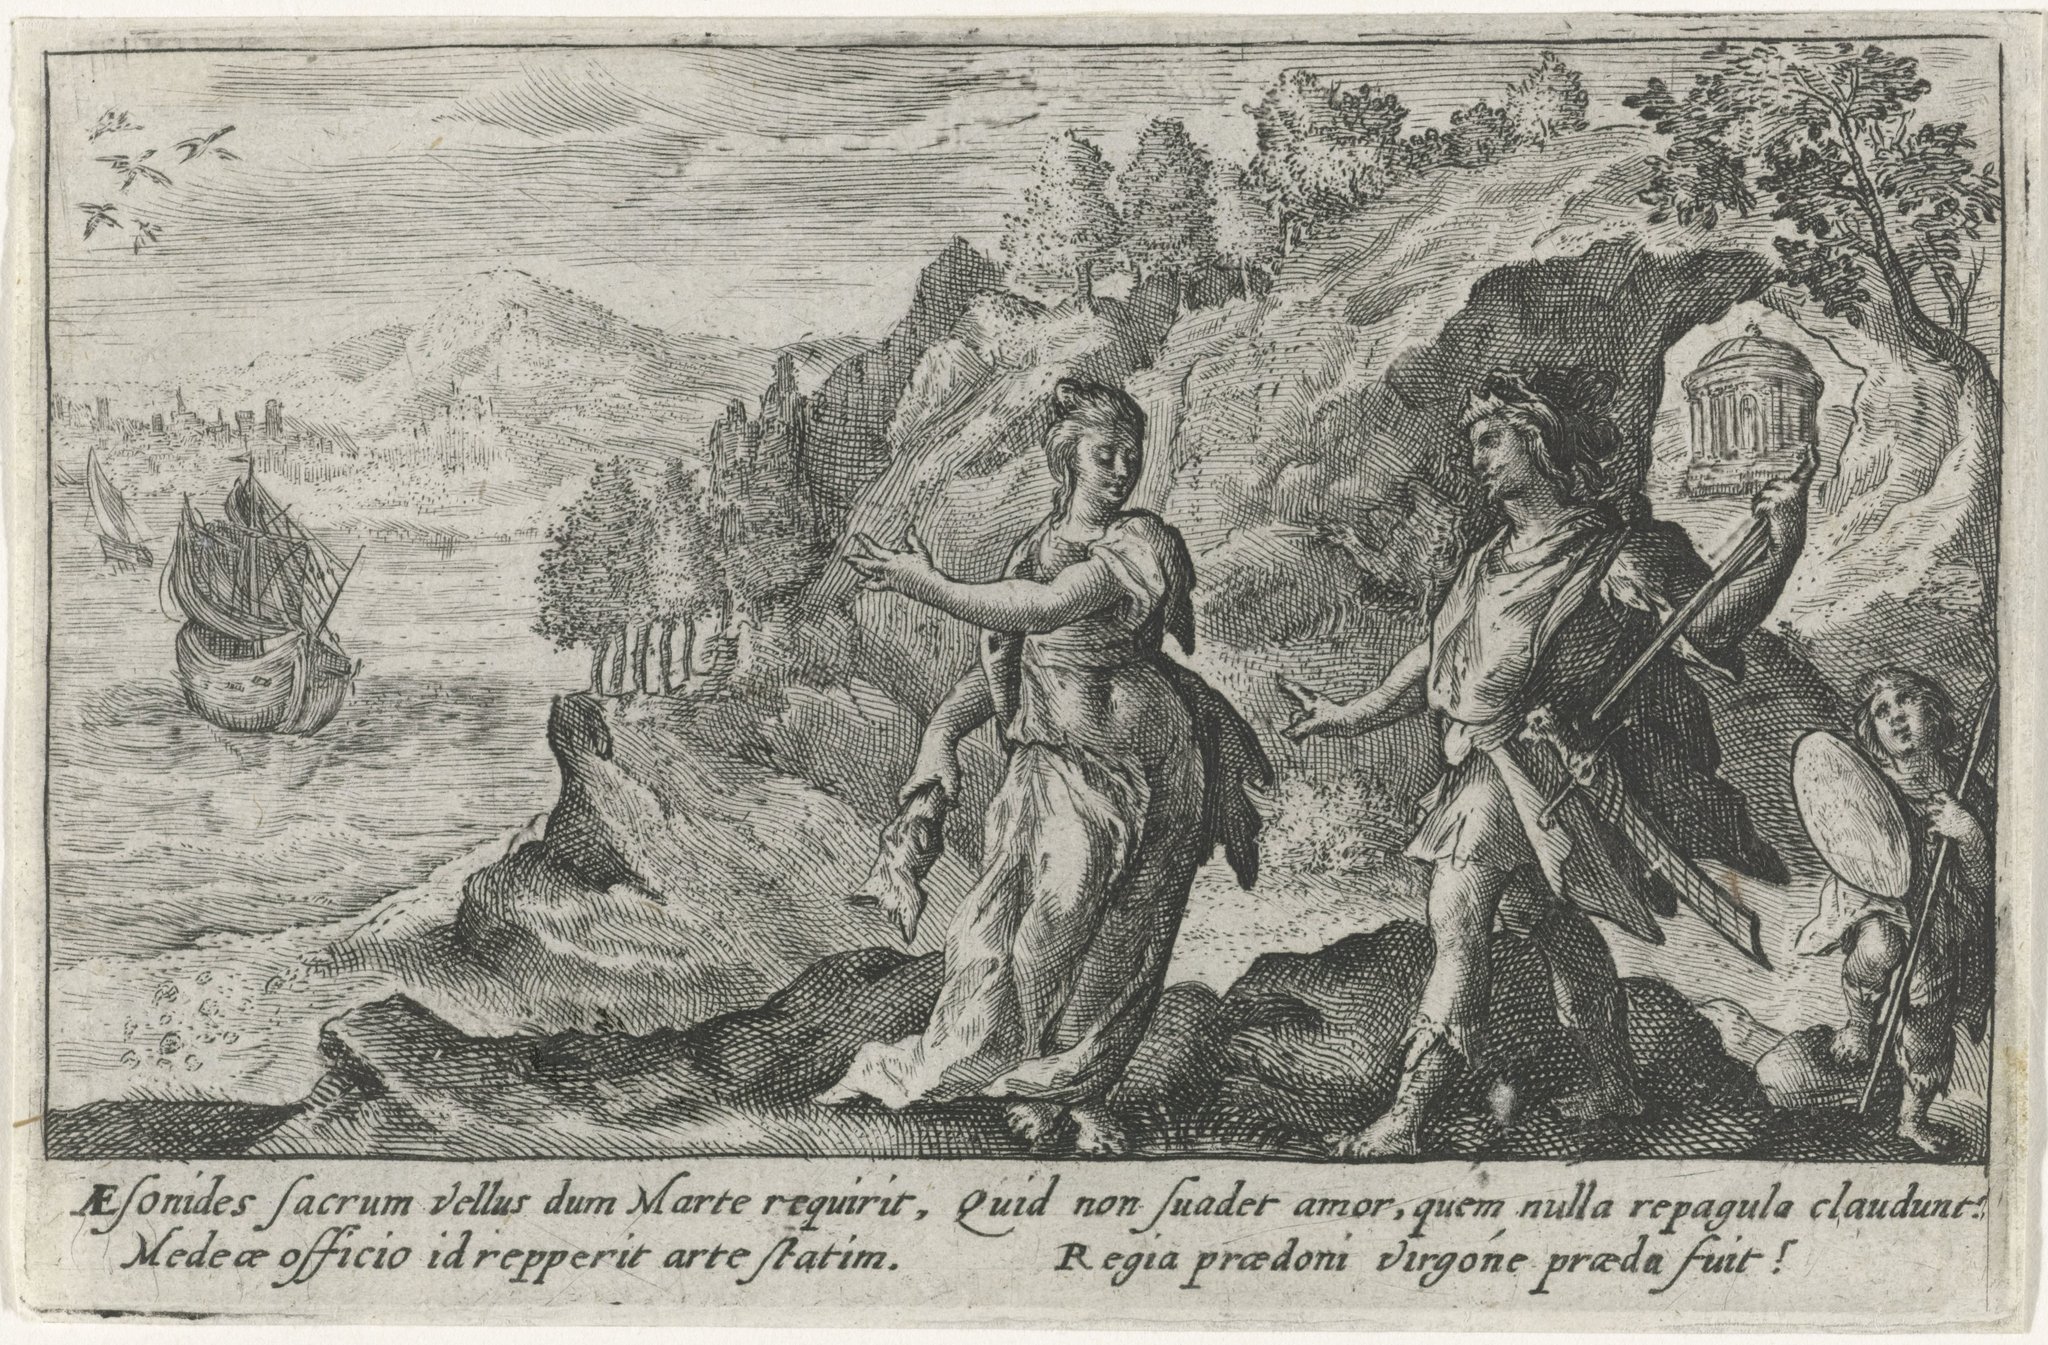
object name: print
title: Metamorfosen van Ovidius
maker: crispijn van de passe (i)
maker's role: draughtsman, print maker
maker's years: 1564-1637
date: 1602-1607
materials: paper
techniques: engraving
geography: cologne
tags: jason and medea at the altar of hecate (or diana): medea gives him a magic herb or ointment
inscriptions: collector's mark: Lugt 2228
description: Medea ontmoet Jason buiten het paleis en overhandigt haar tovermiddelen, waarmee hij de onmogelijke opdrachten die haar vader, koning Aeëtes, hem had gegeven, kan volbrengen. In de marge een vierregelig onderschrift, in twee kolommen, in het Latijn.